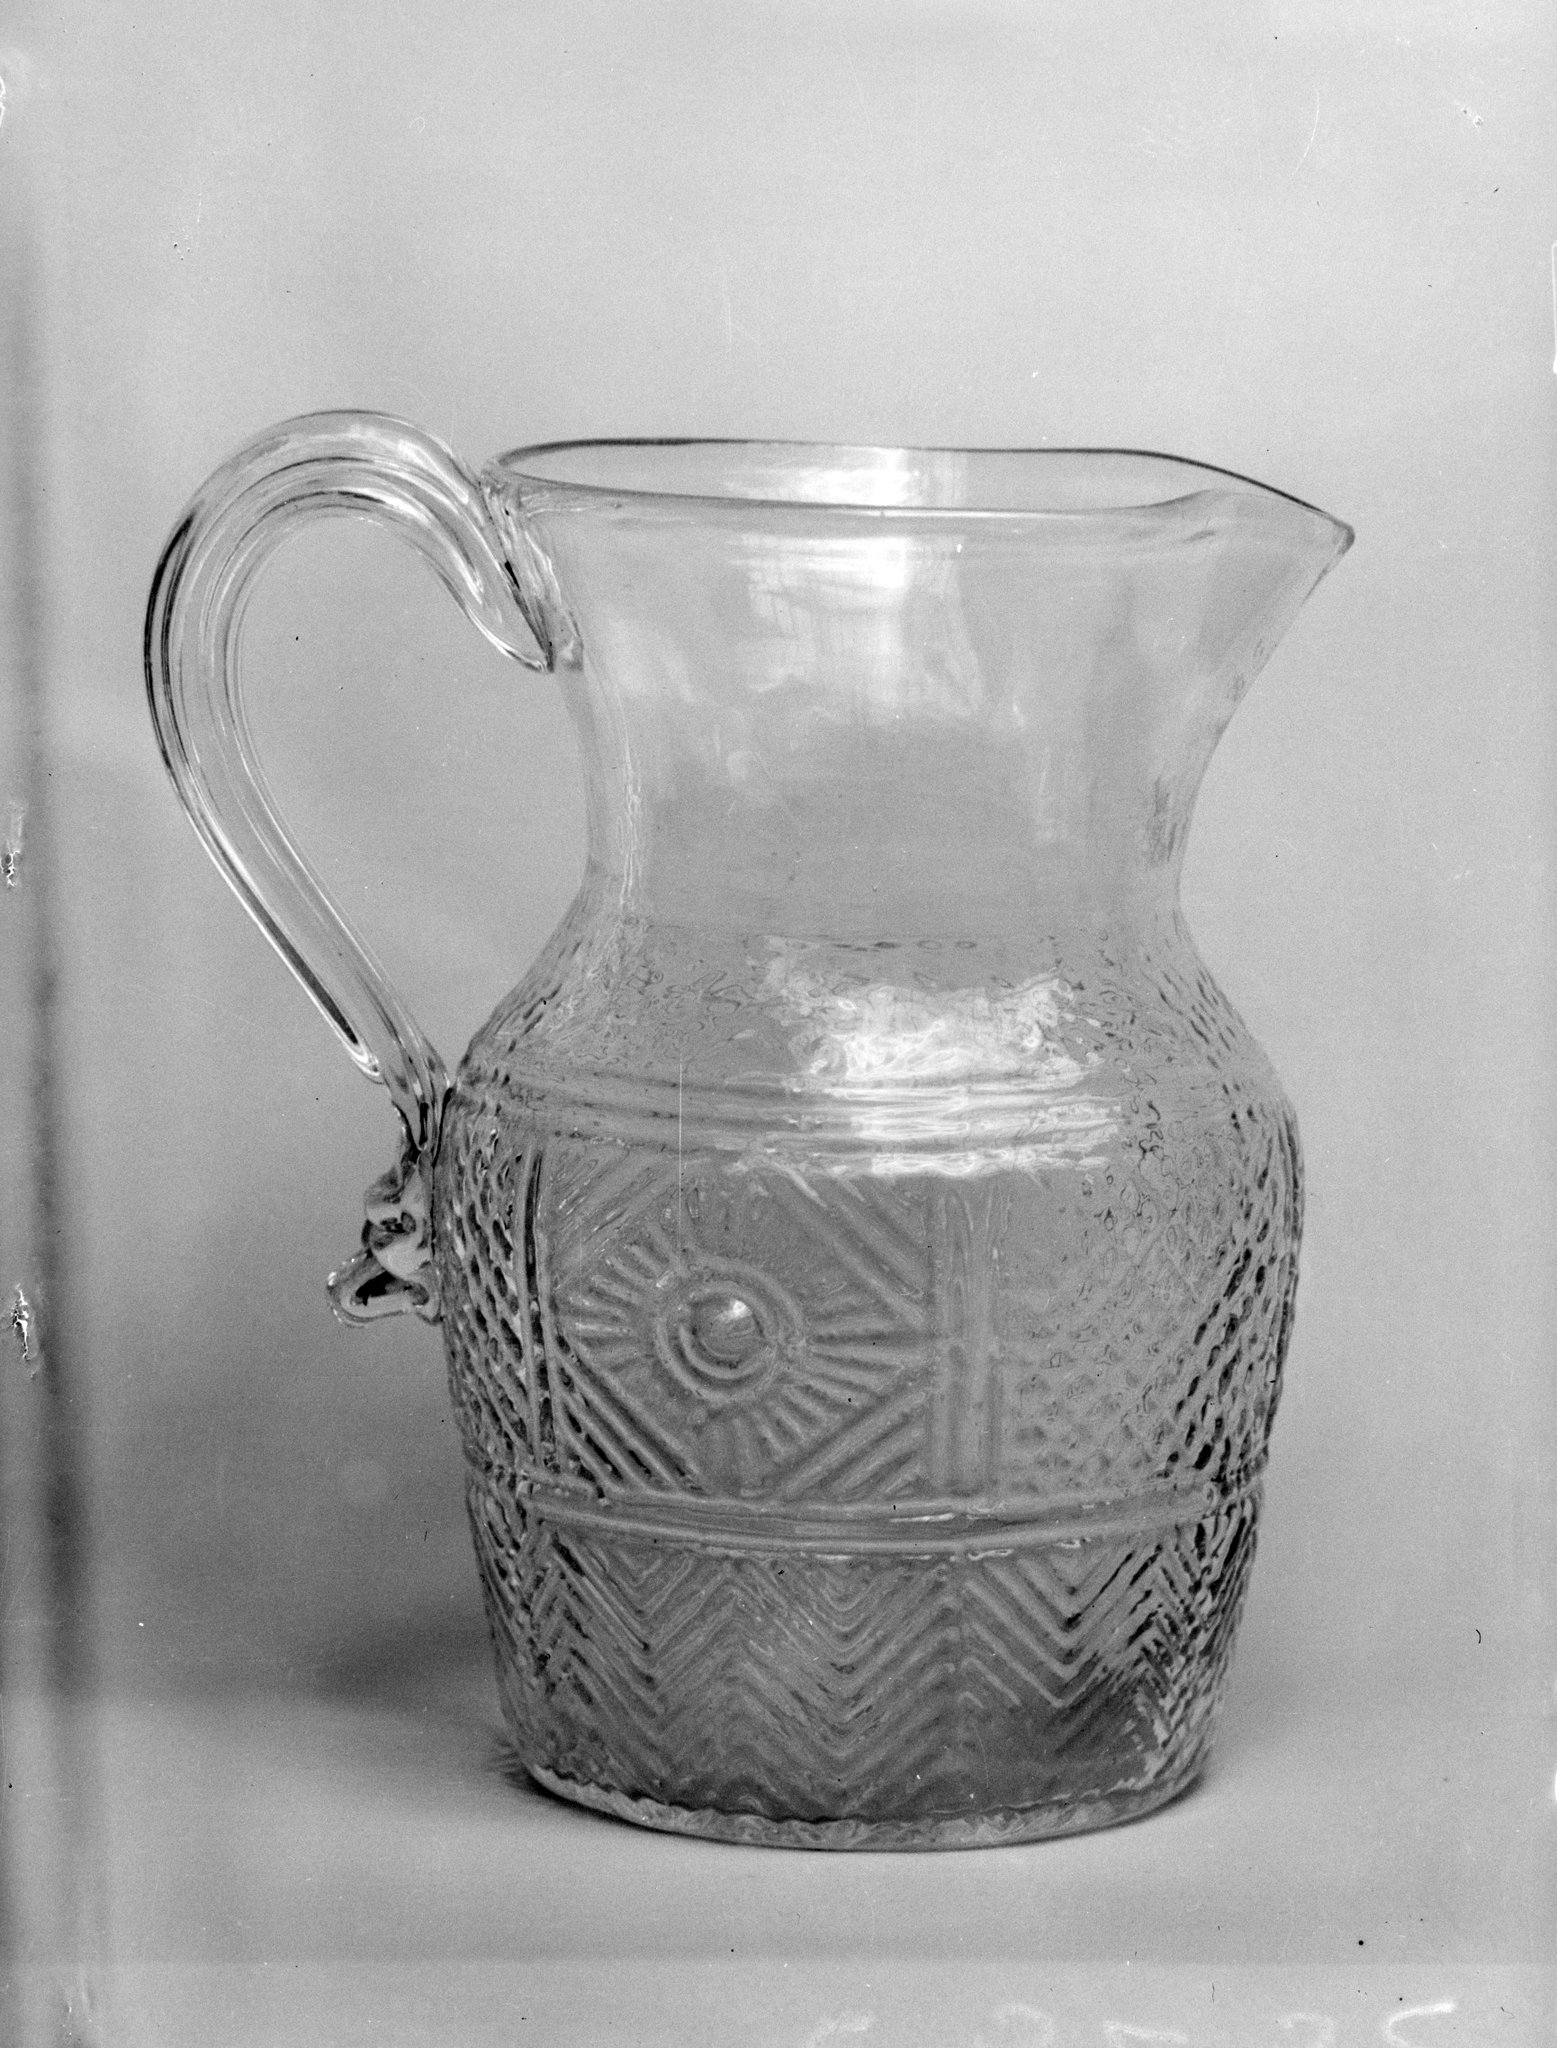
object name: pitcher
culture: american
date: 1820-1840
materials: glass, lead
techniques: glassblowing, molding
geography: united states